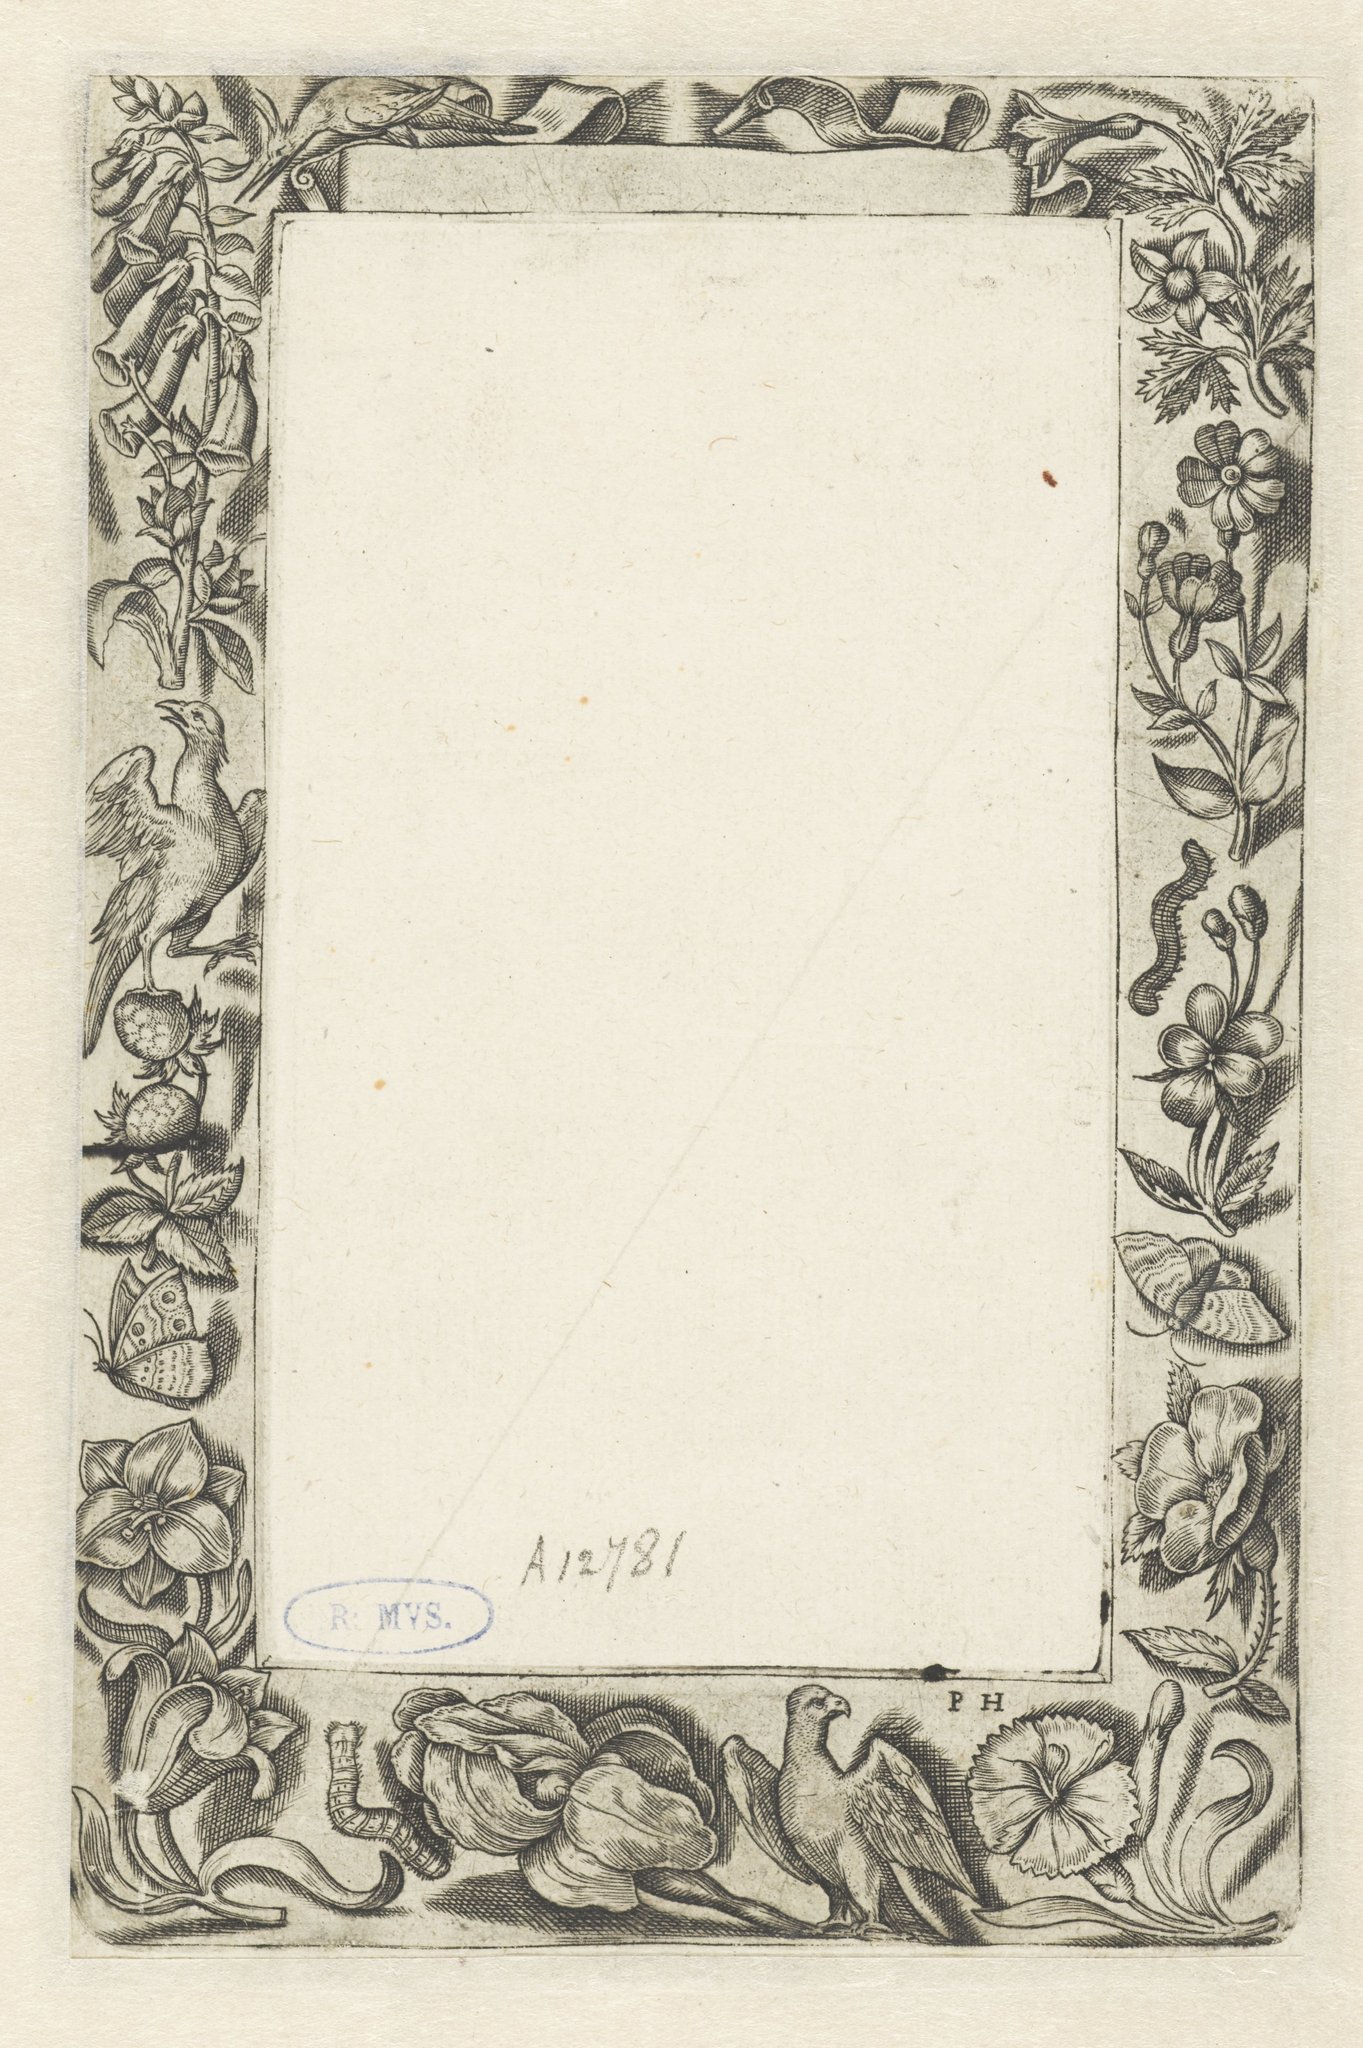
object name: ornament print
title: Omlijstingen met bloemen, vruchten, vogels, insekten en putti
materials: paper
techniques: etching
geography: netherlands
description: Onderaan ligt de bloem van een iris tussen een rups en een vogel. Links zit een vogel op een aardbei. Eén van 6 bladen, aan weerszijden bedrukt, met acht verschillende omlijstingen rondom een niet bedrukt middenveld.